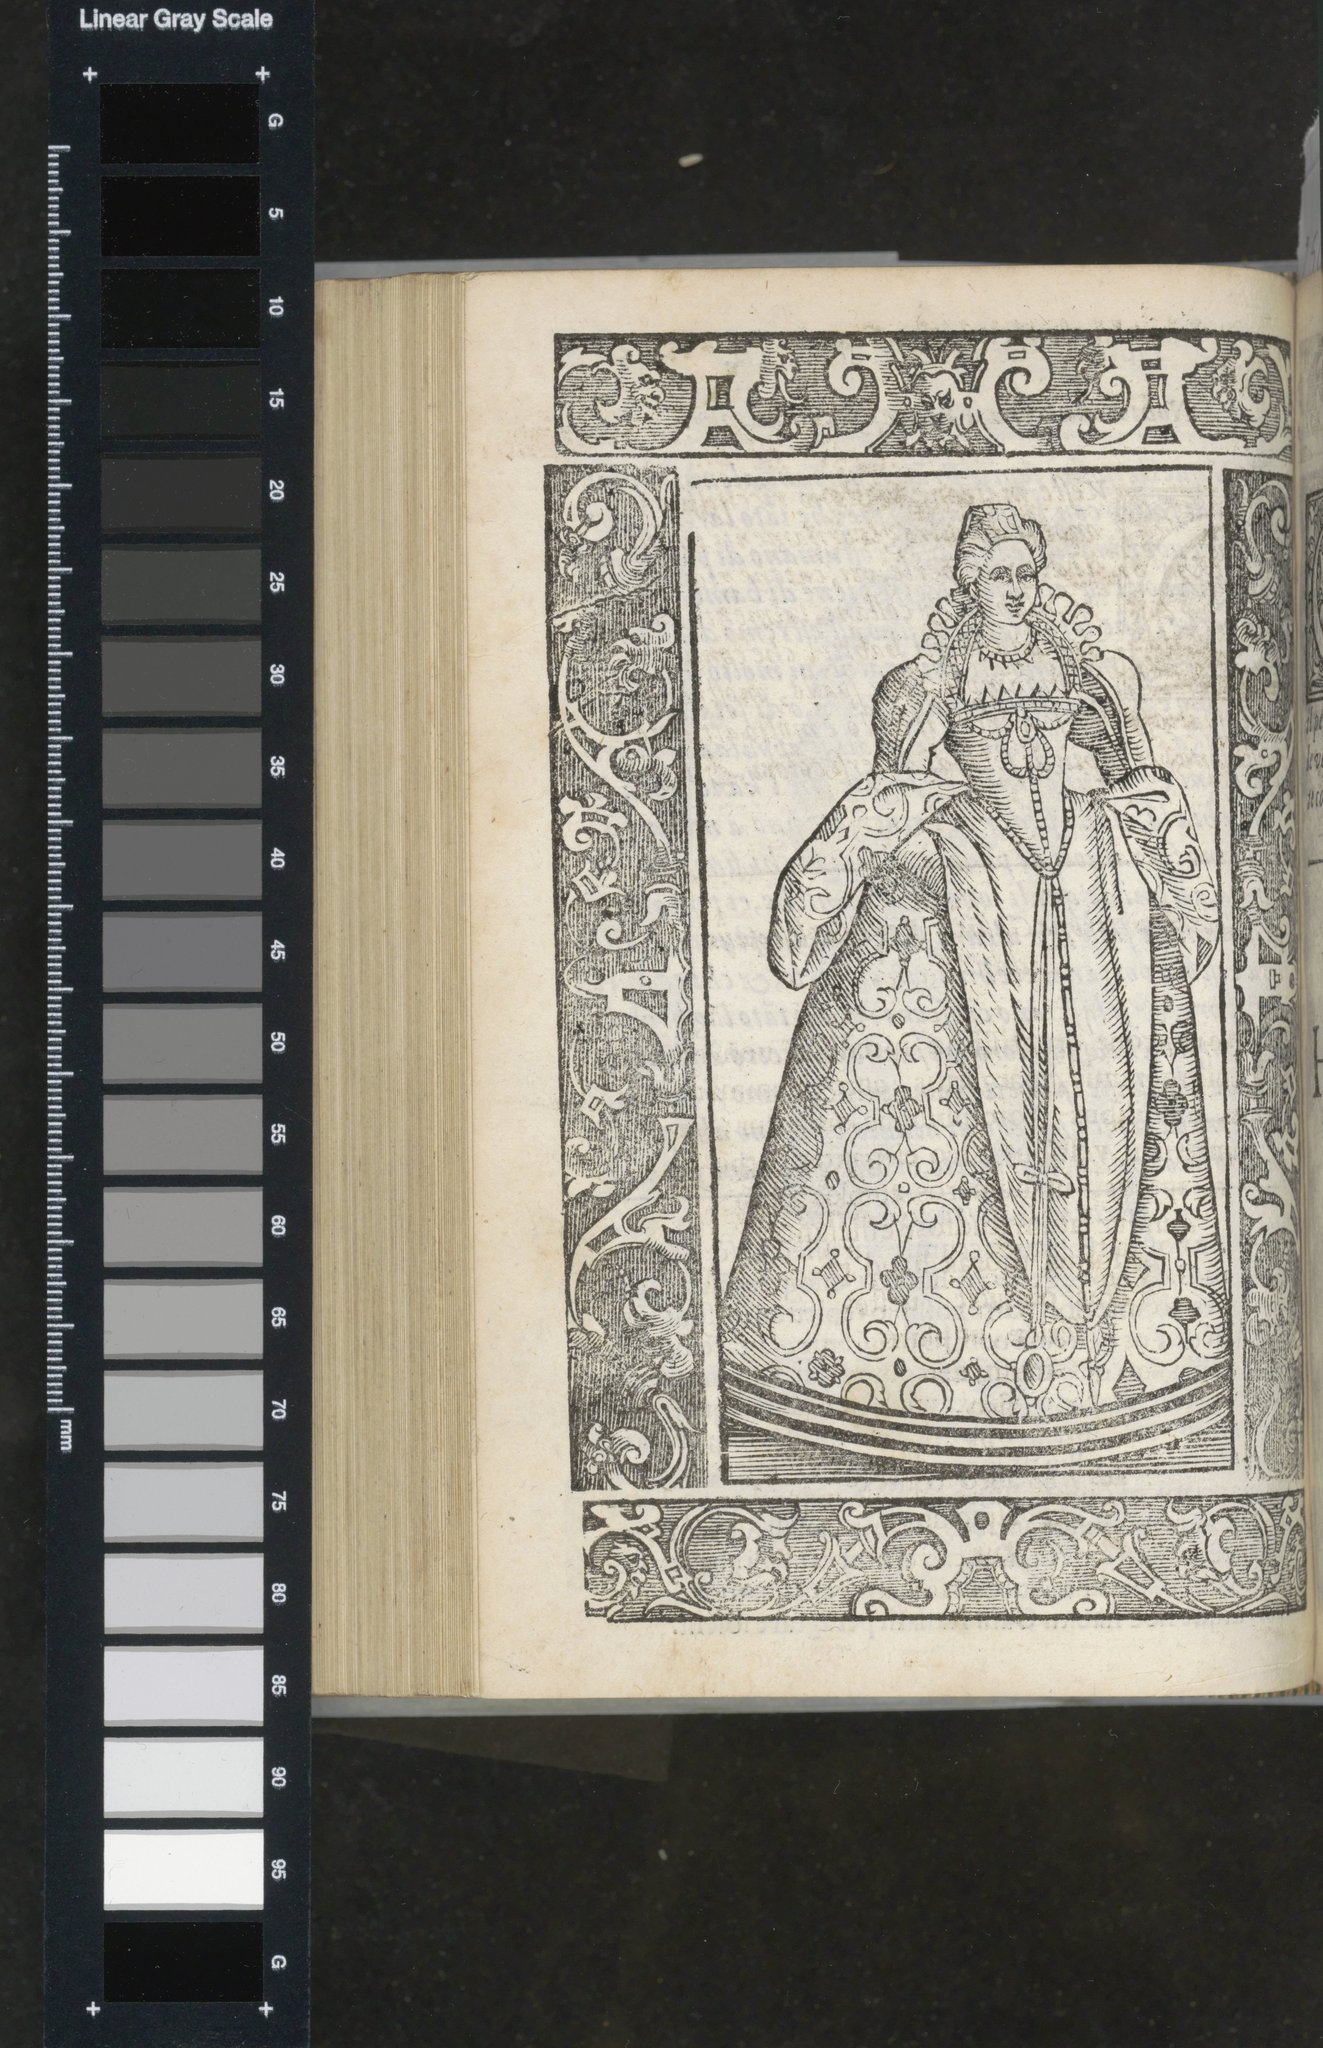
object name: costume print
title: Nobile matrona franchese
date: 1598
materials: paper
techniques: woodcut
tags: fashion plates